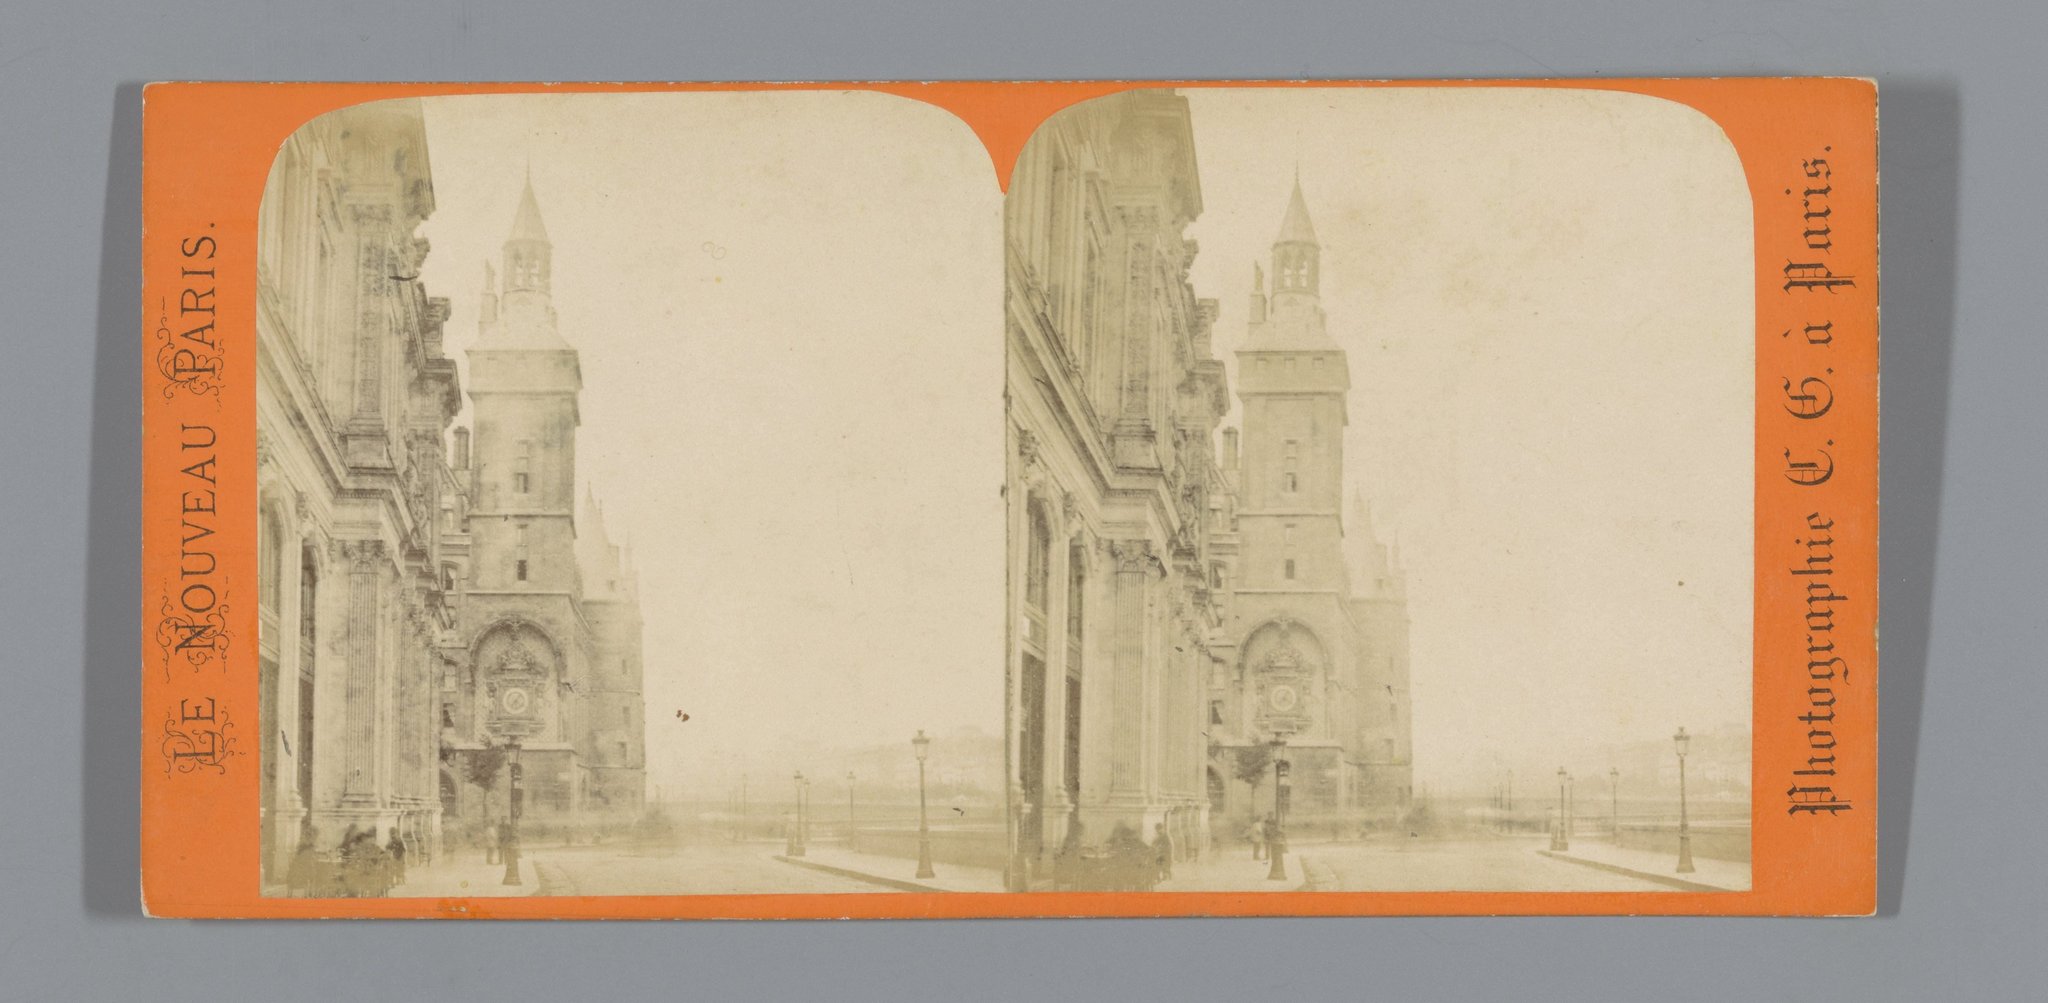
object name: stereograph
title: Le Nouveau Paris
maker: charles gérard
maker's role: fotograaf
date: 1860-1870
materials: cardboard, photographic support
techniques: albumen print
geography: paris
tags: tower, clock tower ~ monumental adornment, façade (of house or building)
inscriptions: inscription: ‘Tour de l'Horloge’, inscription: ‘Photographie C. G. à Paris.’